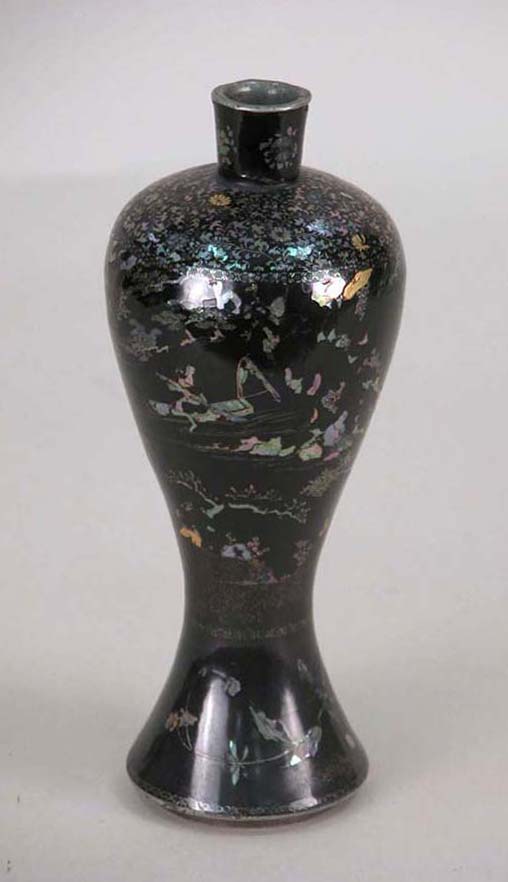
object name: vase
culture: chinese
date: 1701-1800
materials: lacquer, pewter